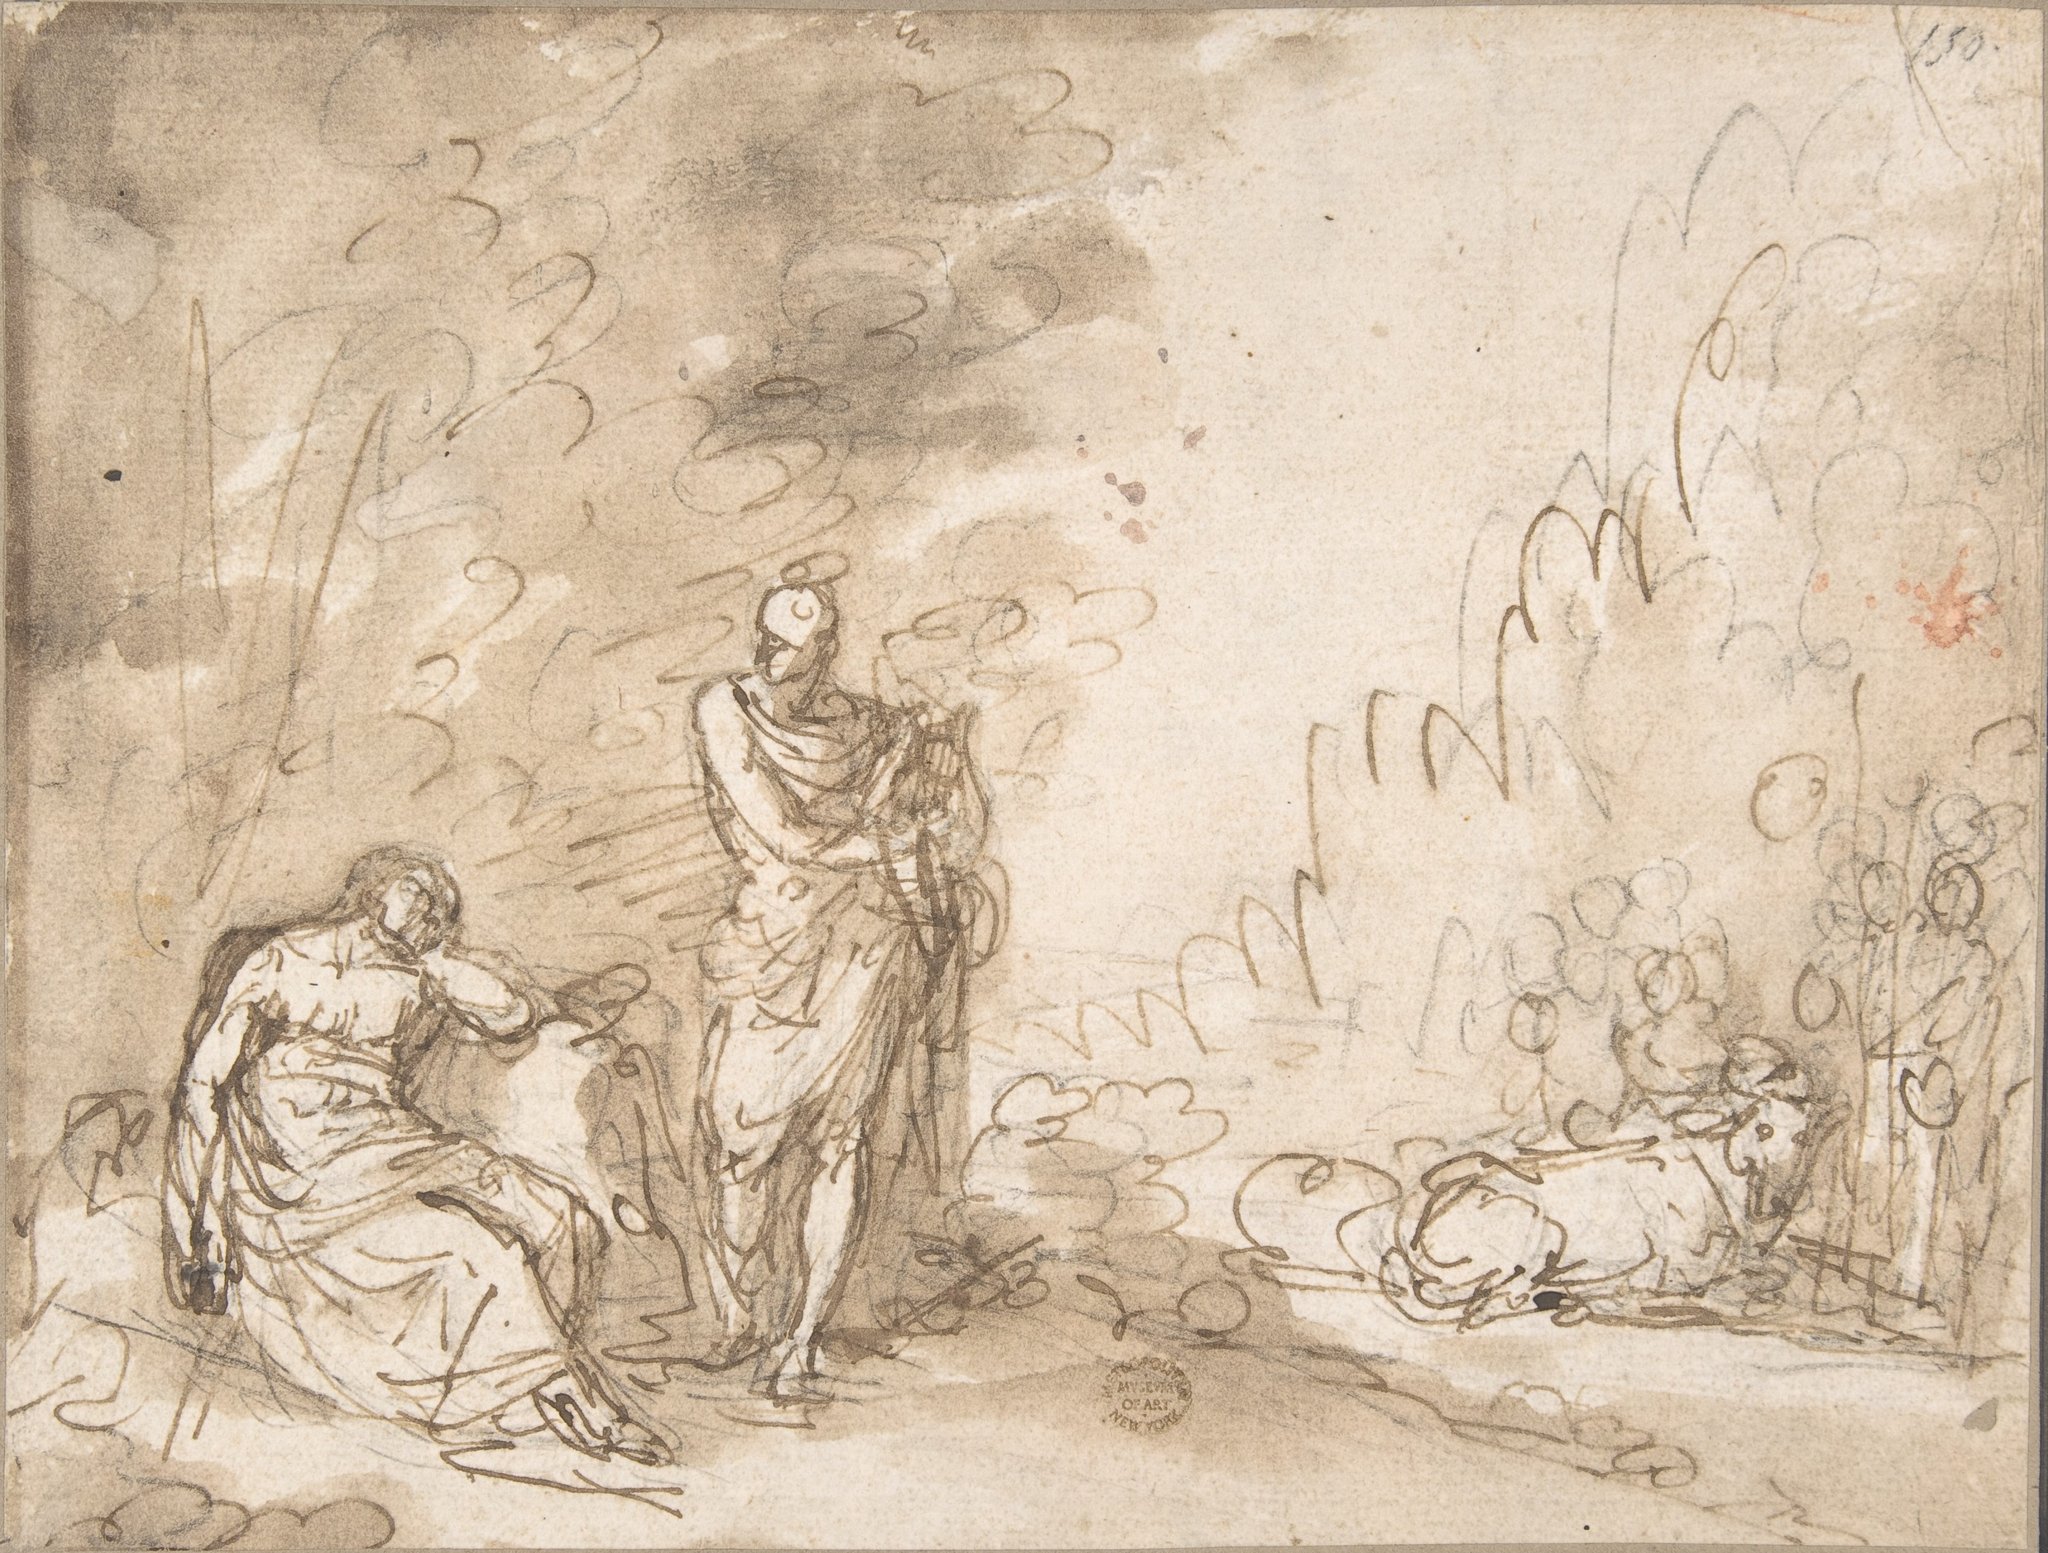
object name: drawing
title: Scene with Apollo? Orpheus?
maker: anonymous, italian, roman-bolognese, 17th century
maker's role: artist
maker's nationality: italian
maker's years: 1600-1700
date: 1601-1700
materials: chalk, ink, paper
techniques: brush, pen, wash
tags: animals,apollo,orpheus